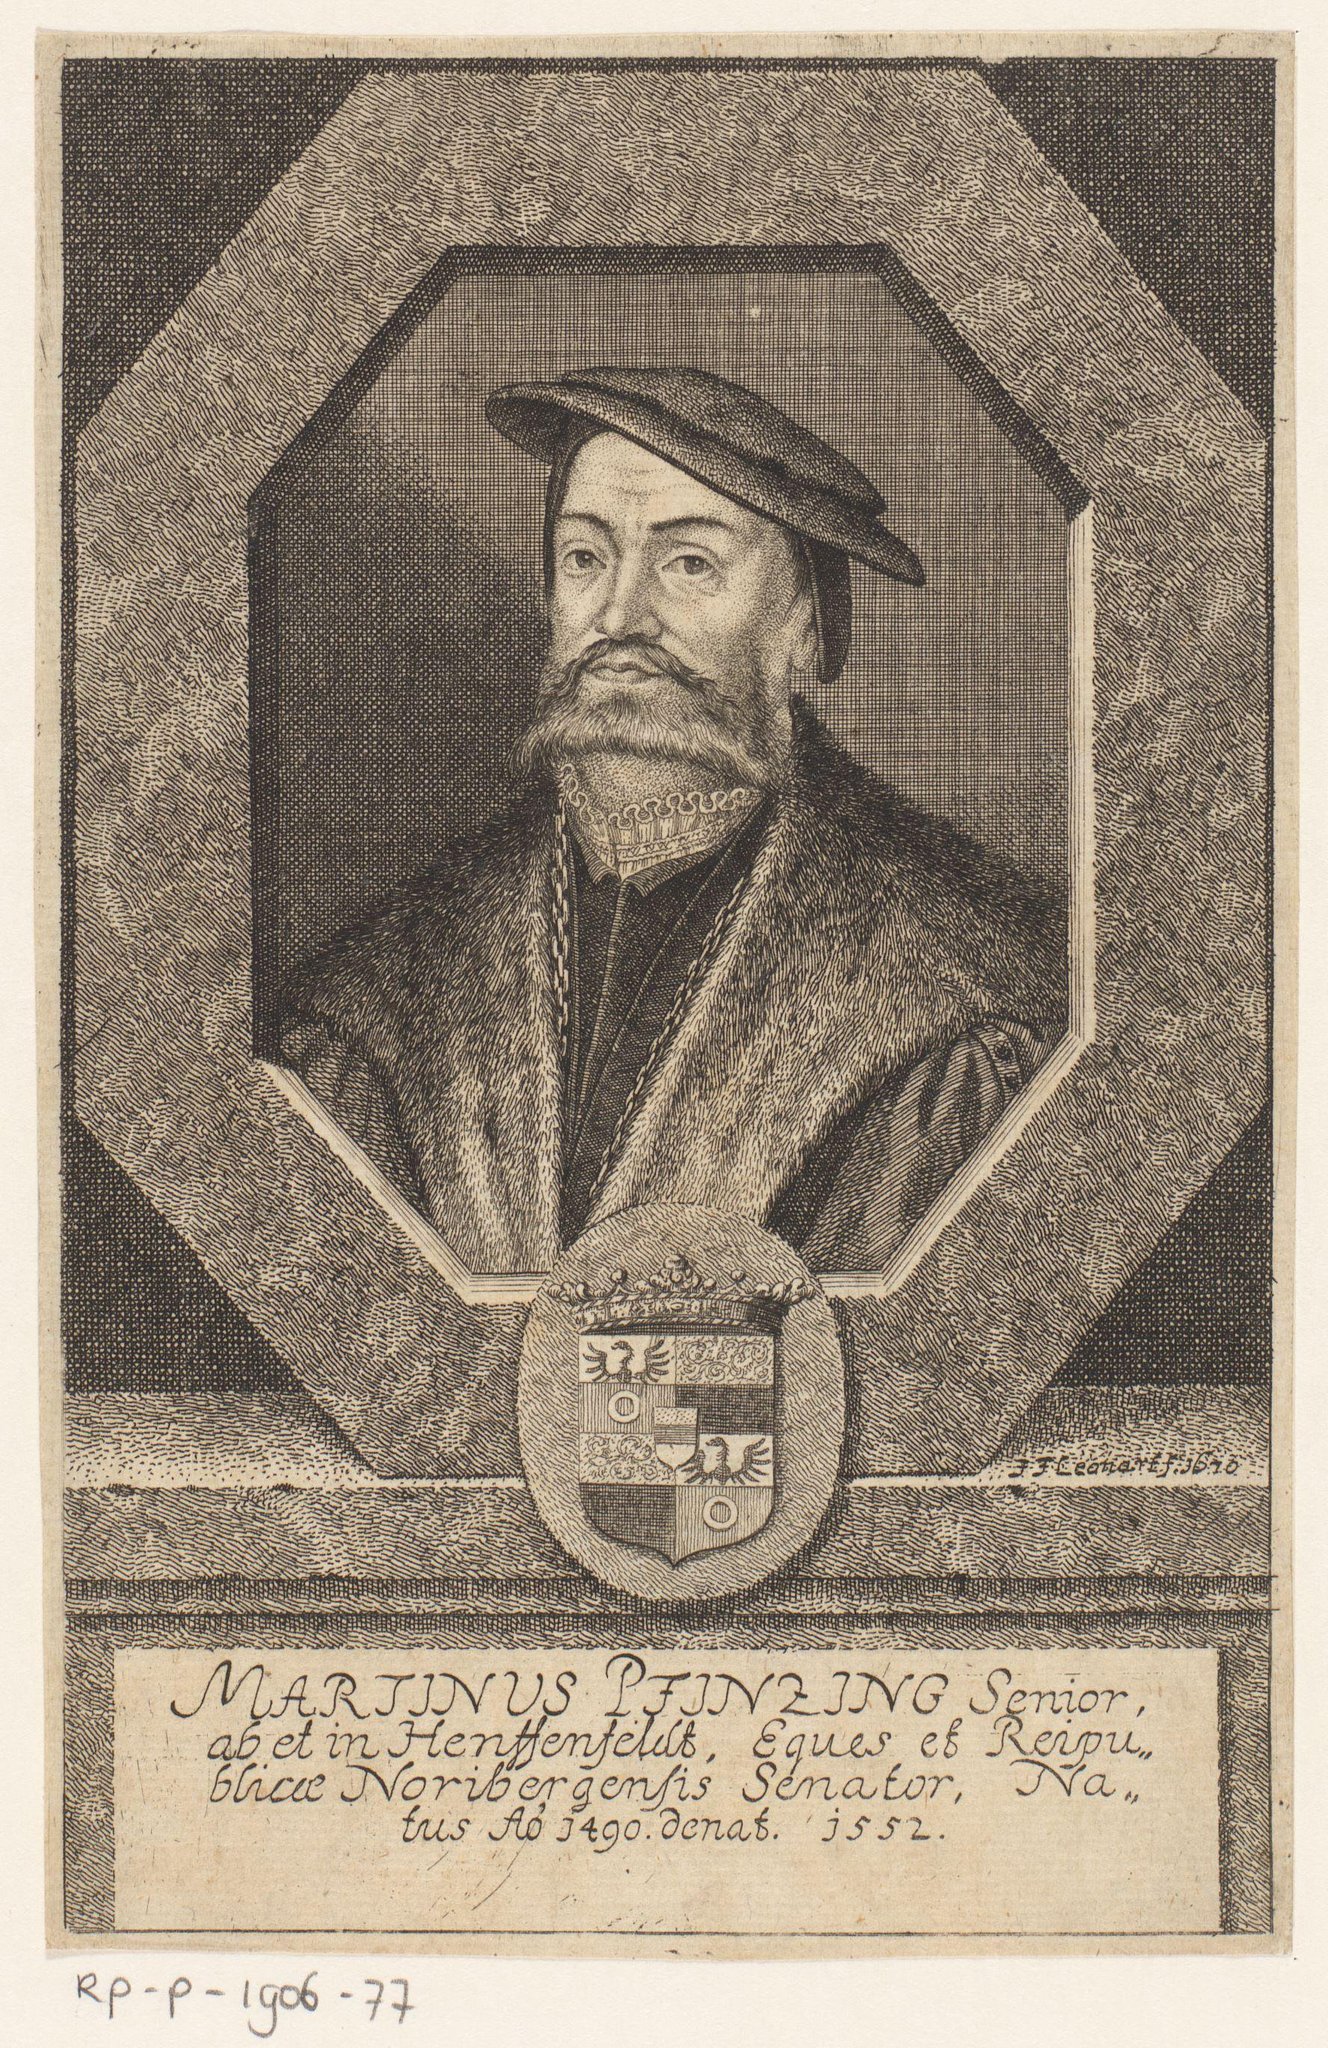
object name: print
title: Portret van Martin Pfintzing von Hefenfeld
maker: johann friedrich leonard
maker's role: print maker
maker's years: 1633-1680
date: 1670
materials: paper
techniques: engraving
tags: senator, martin pfintzing von hefenfeld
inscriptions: collector's mark: Lugt 2228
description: Portret van Martin Pfintzing von Hefenfeld, senator te Neurenberg.